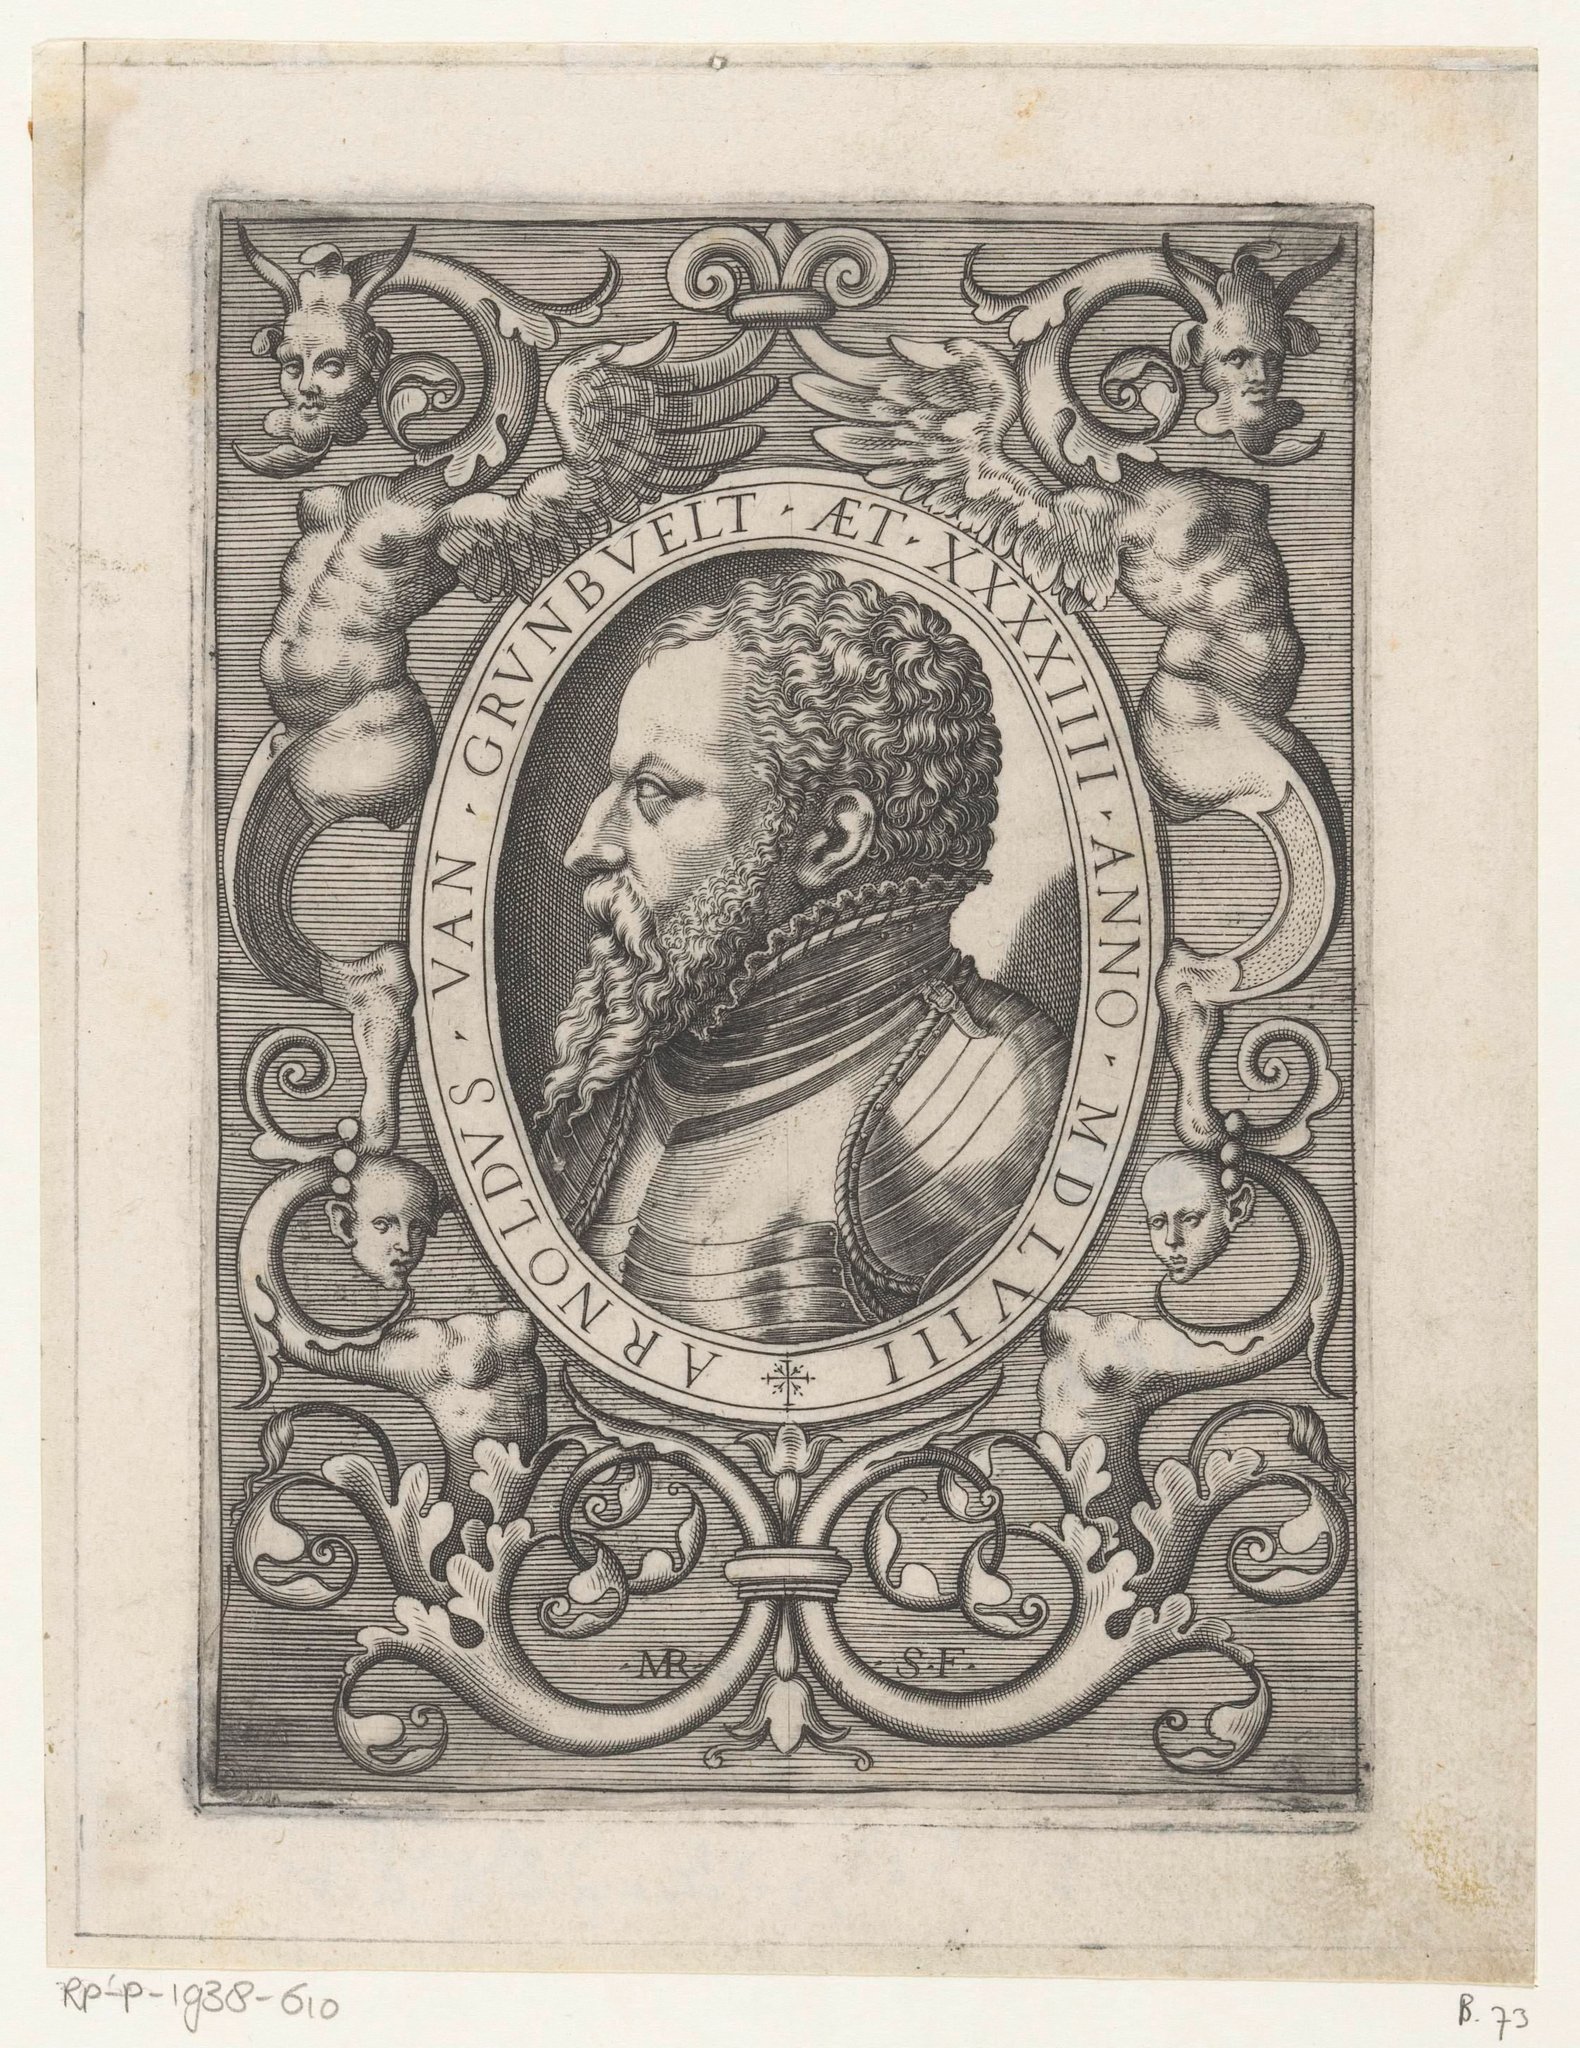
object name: print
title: Portret van Arnoldus van Grunbuelt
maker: martino rota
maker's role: print maker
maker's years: 1520-1583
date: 1558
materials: paper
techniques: engraving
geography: italy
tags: historical persons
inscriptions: collector's mark: Lugt 2228